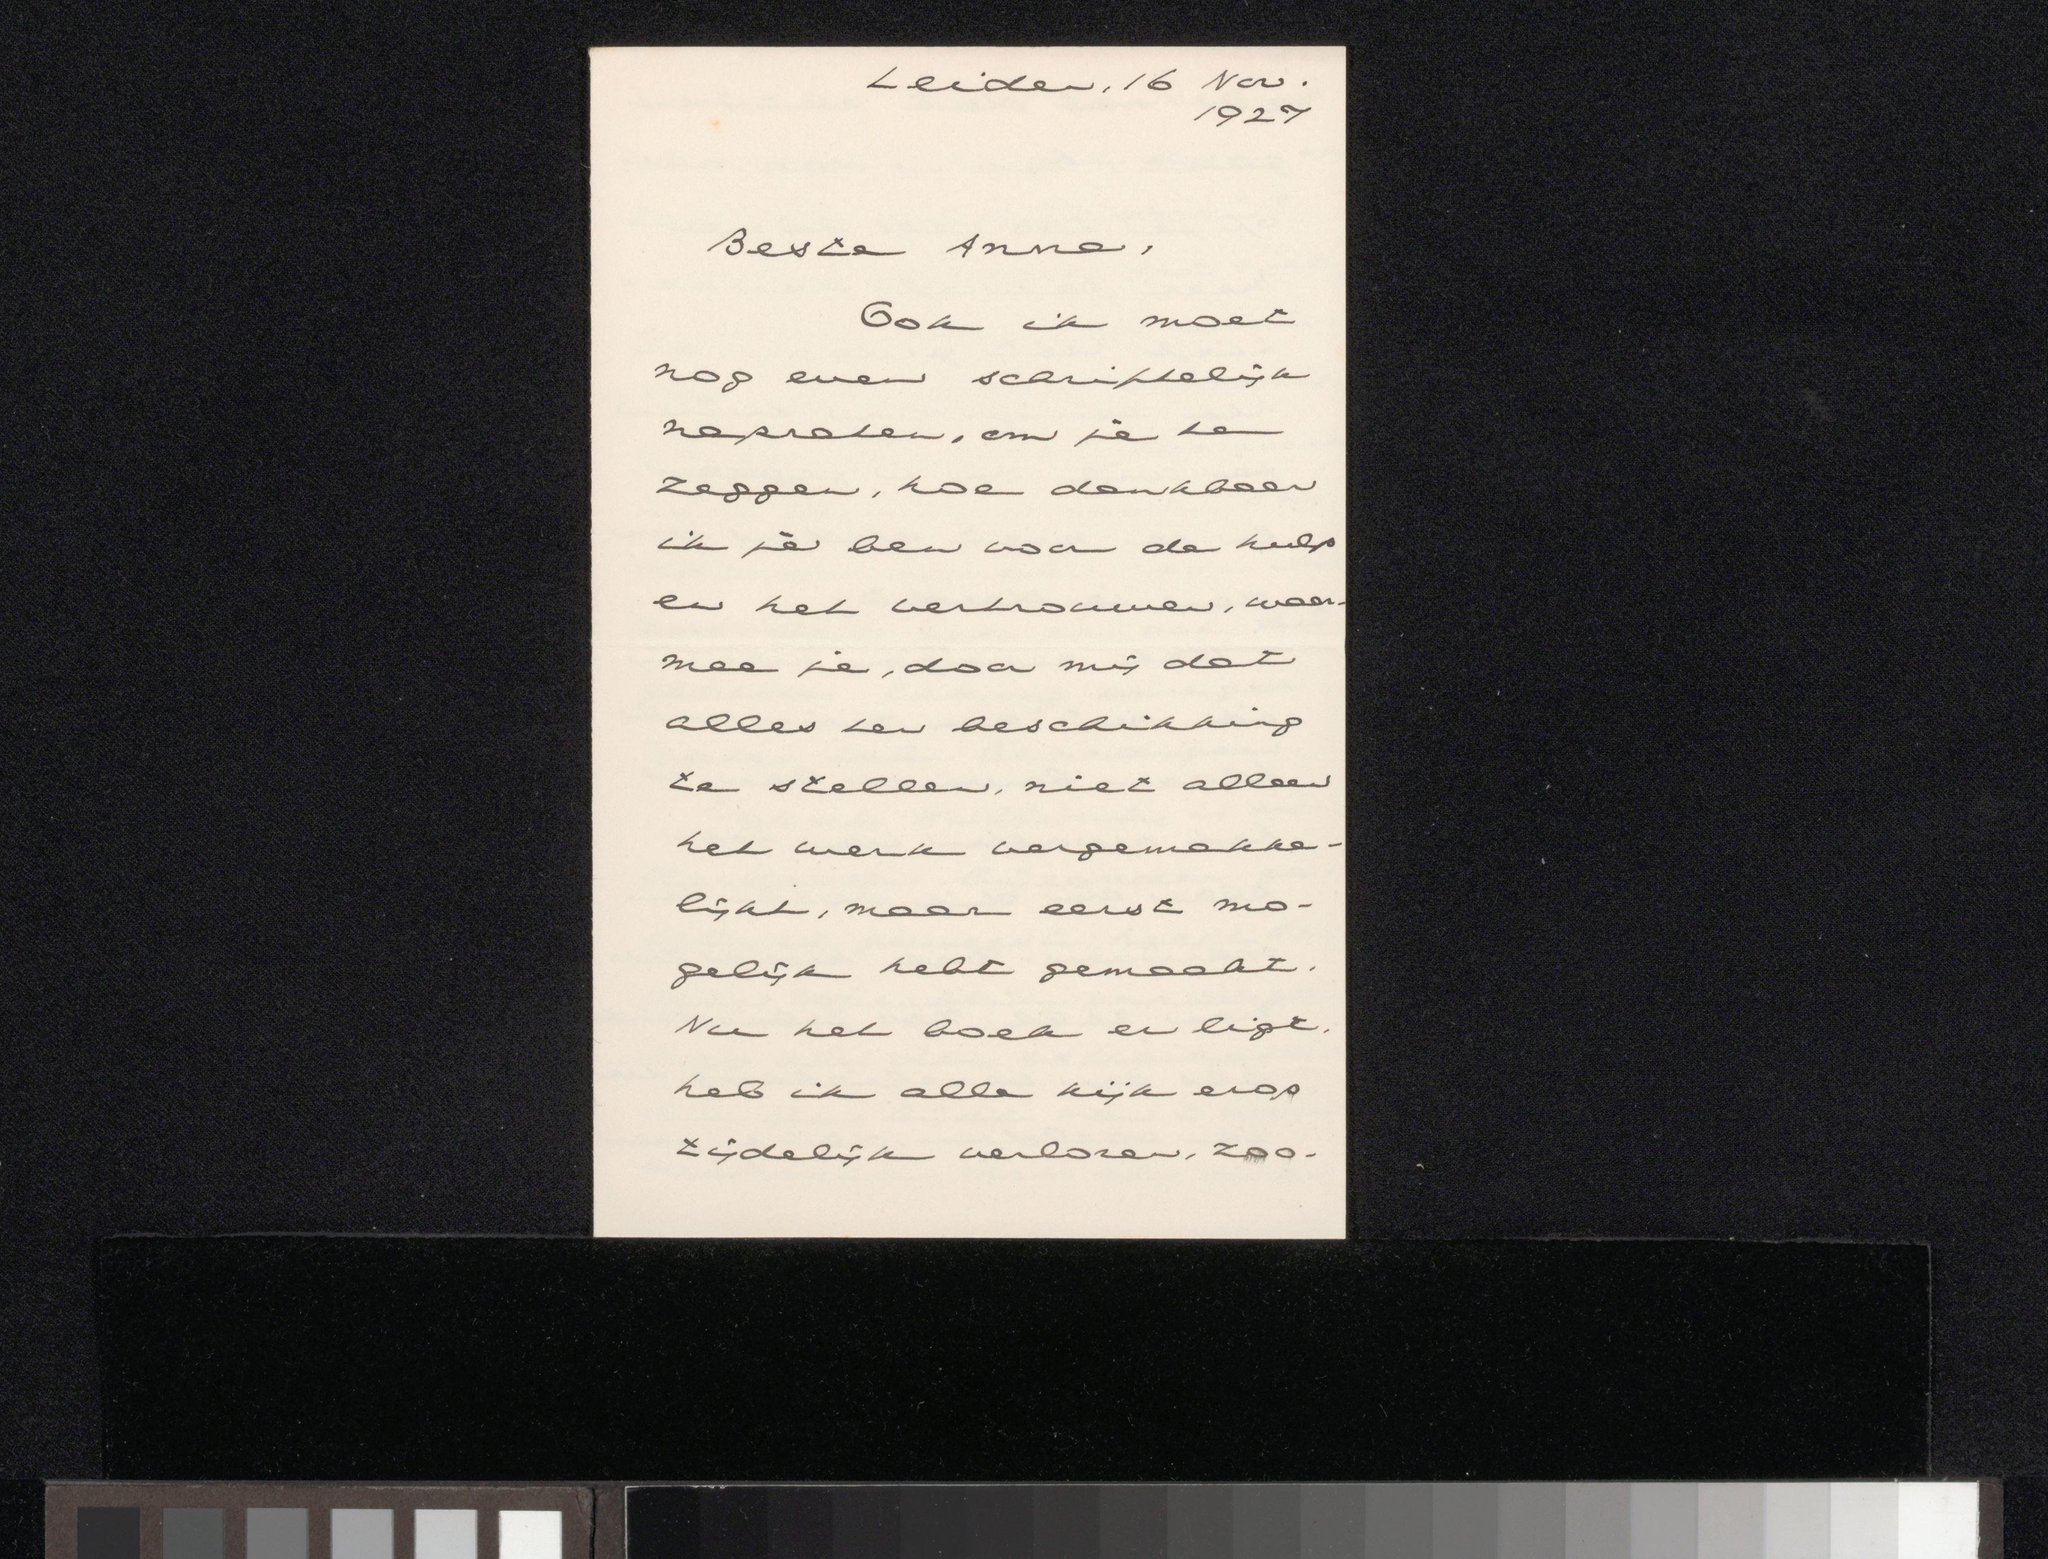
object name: letter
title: Brief aan Anna Dorothea Dirks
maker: johan huizinga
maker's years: 1872-1945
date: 1927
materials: ink, paper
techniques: pen, writing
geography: leiden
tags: artist, anna dorothea dirks, haarlem, hermanus diedericus tjeenk willink (1843-1917)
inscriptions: watermark, collector's mark: ‘RPK’